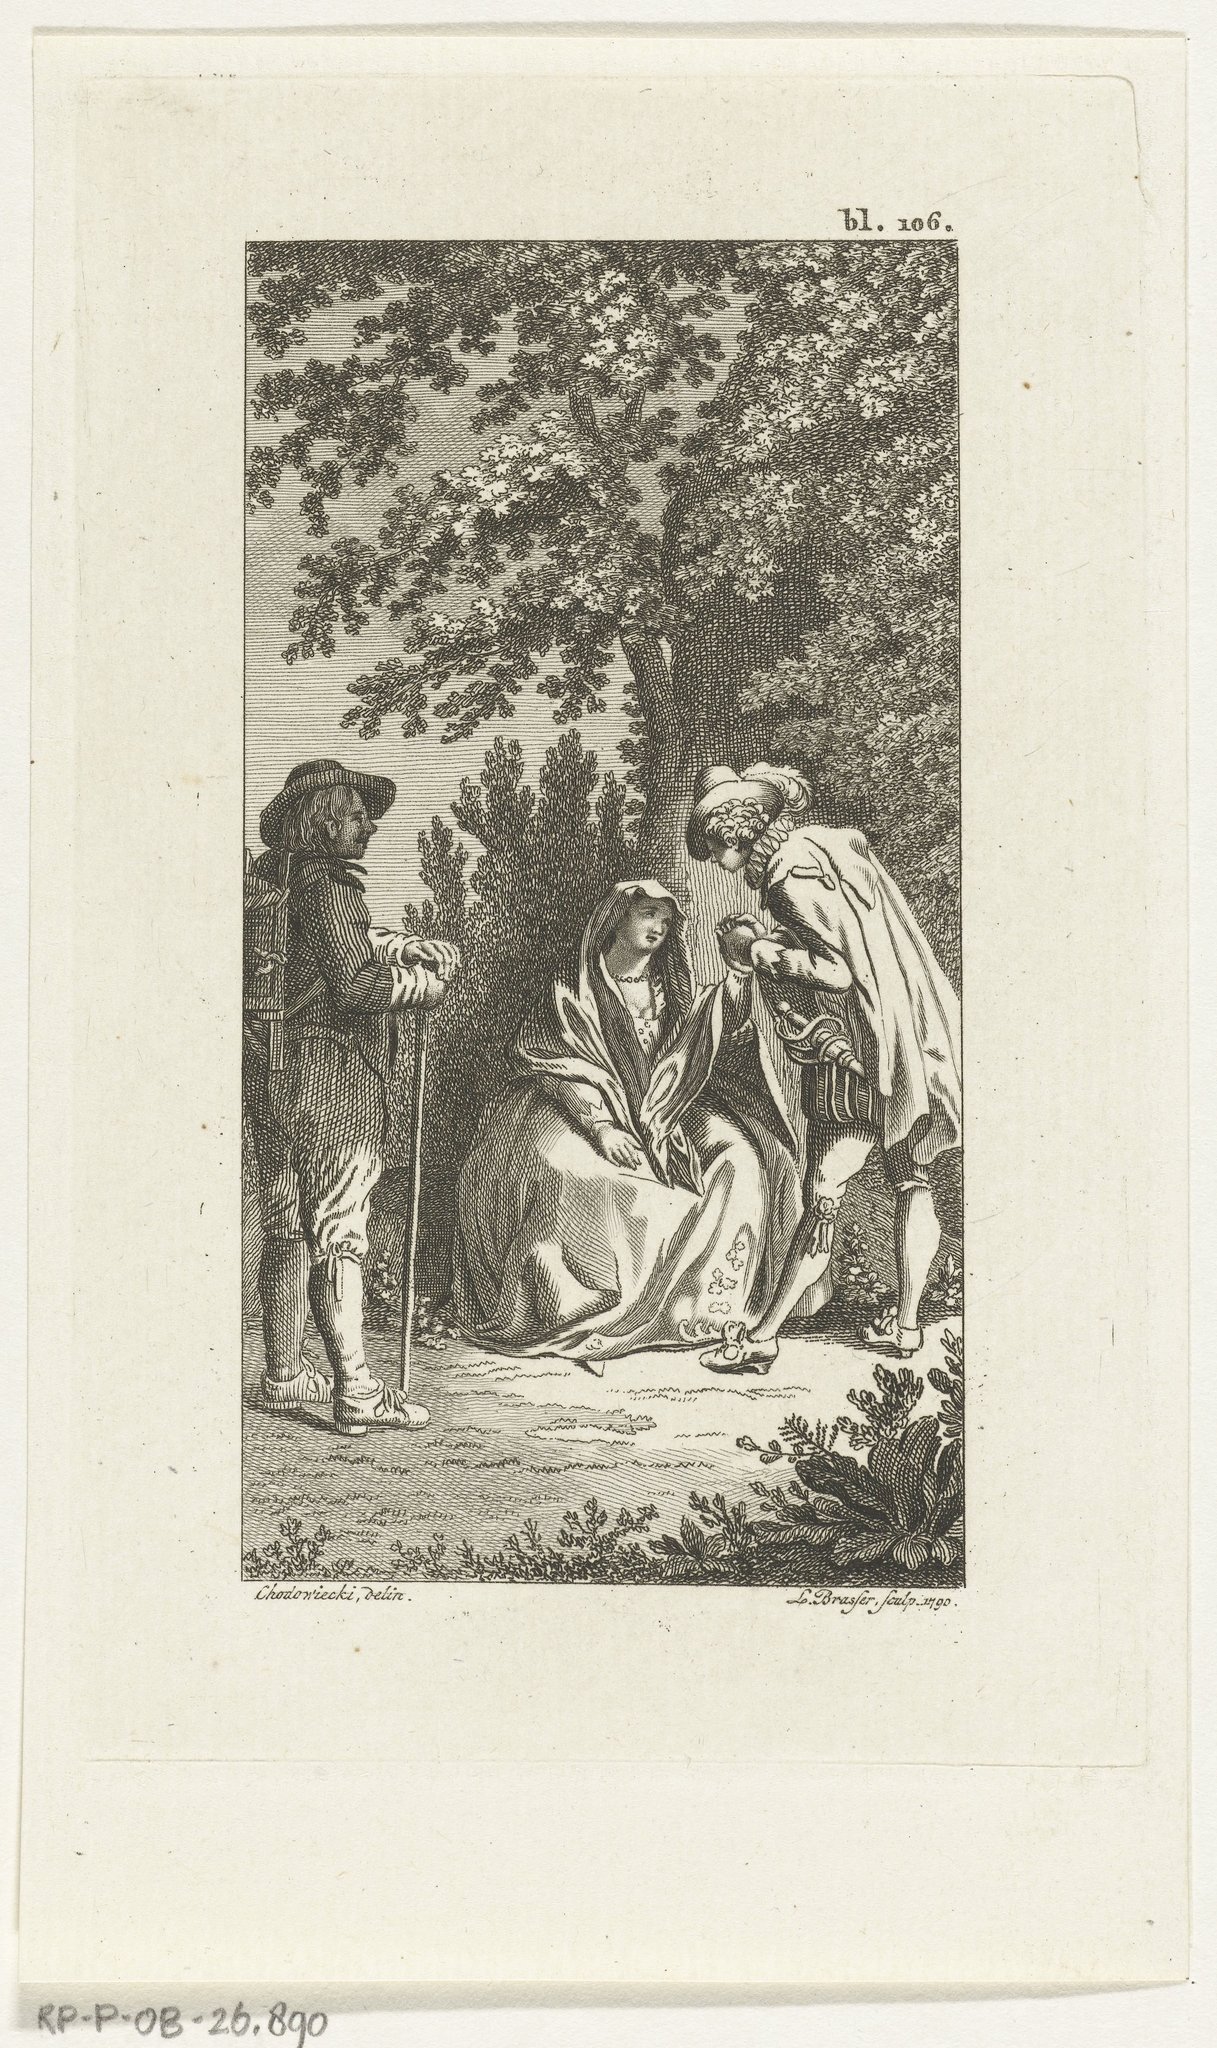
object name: book illustration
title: Dame wordt het hof gemaakt door heer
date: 1727-1793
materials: paper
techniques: engraving, etching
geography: netherlands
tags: courting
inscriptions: collector's mark: Lugt 2228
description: Prent naar tekening van Chodowiecki. Boekillustratie uit onbekende uitgave bij pagina 106.